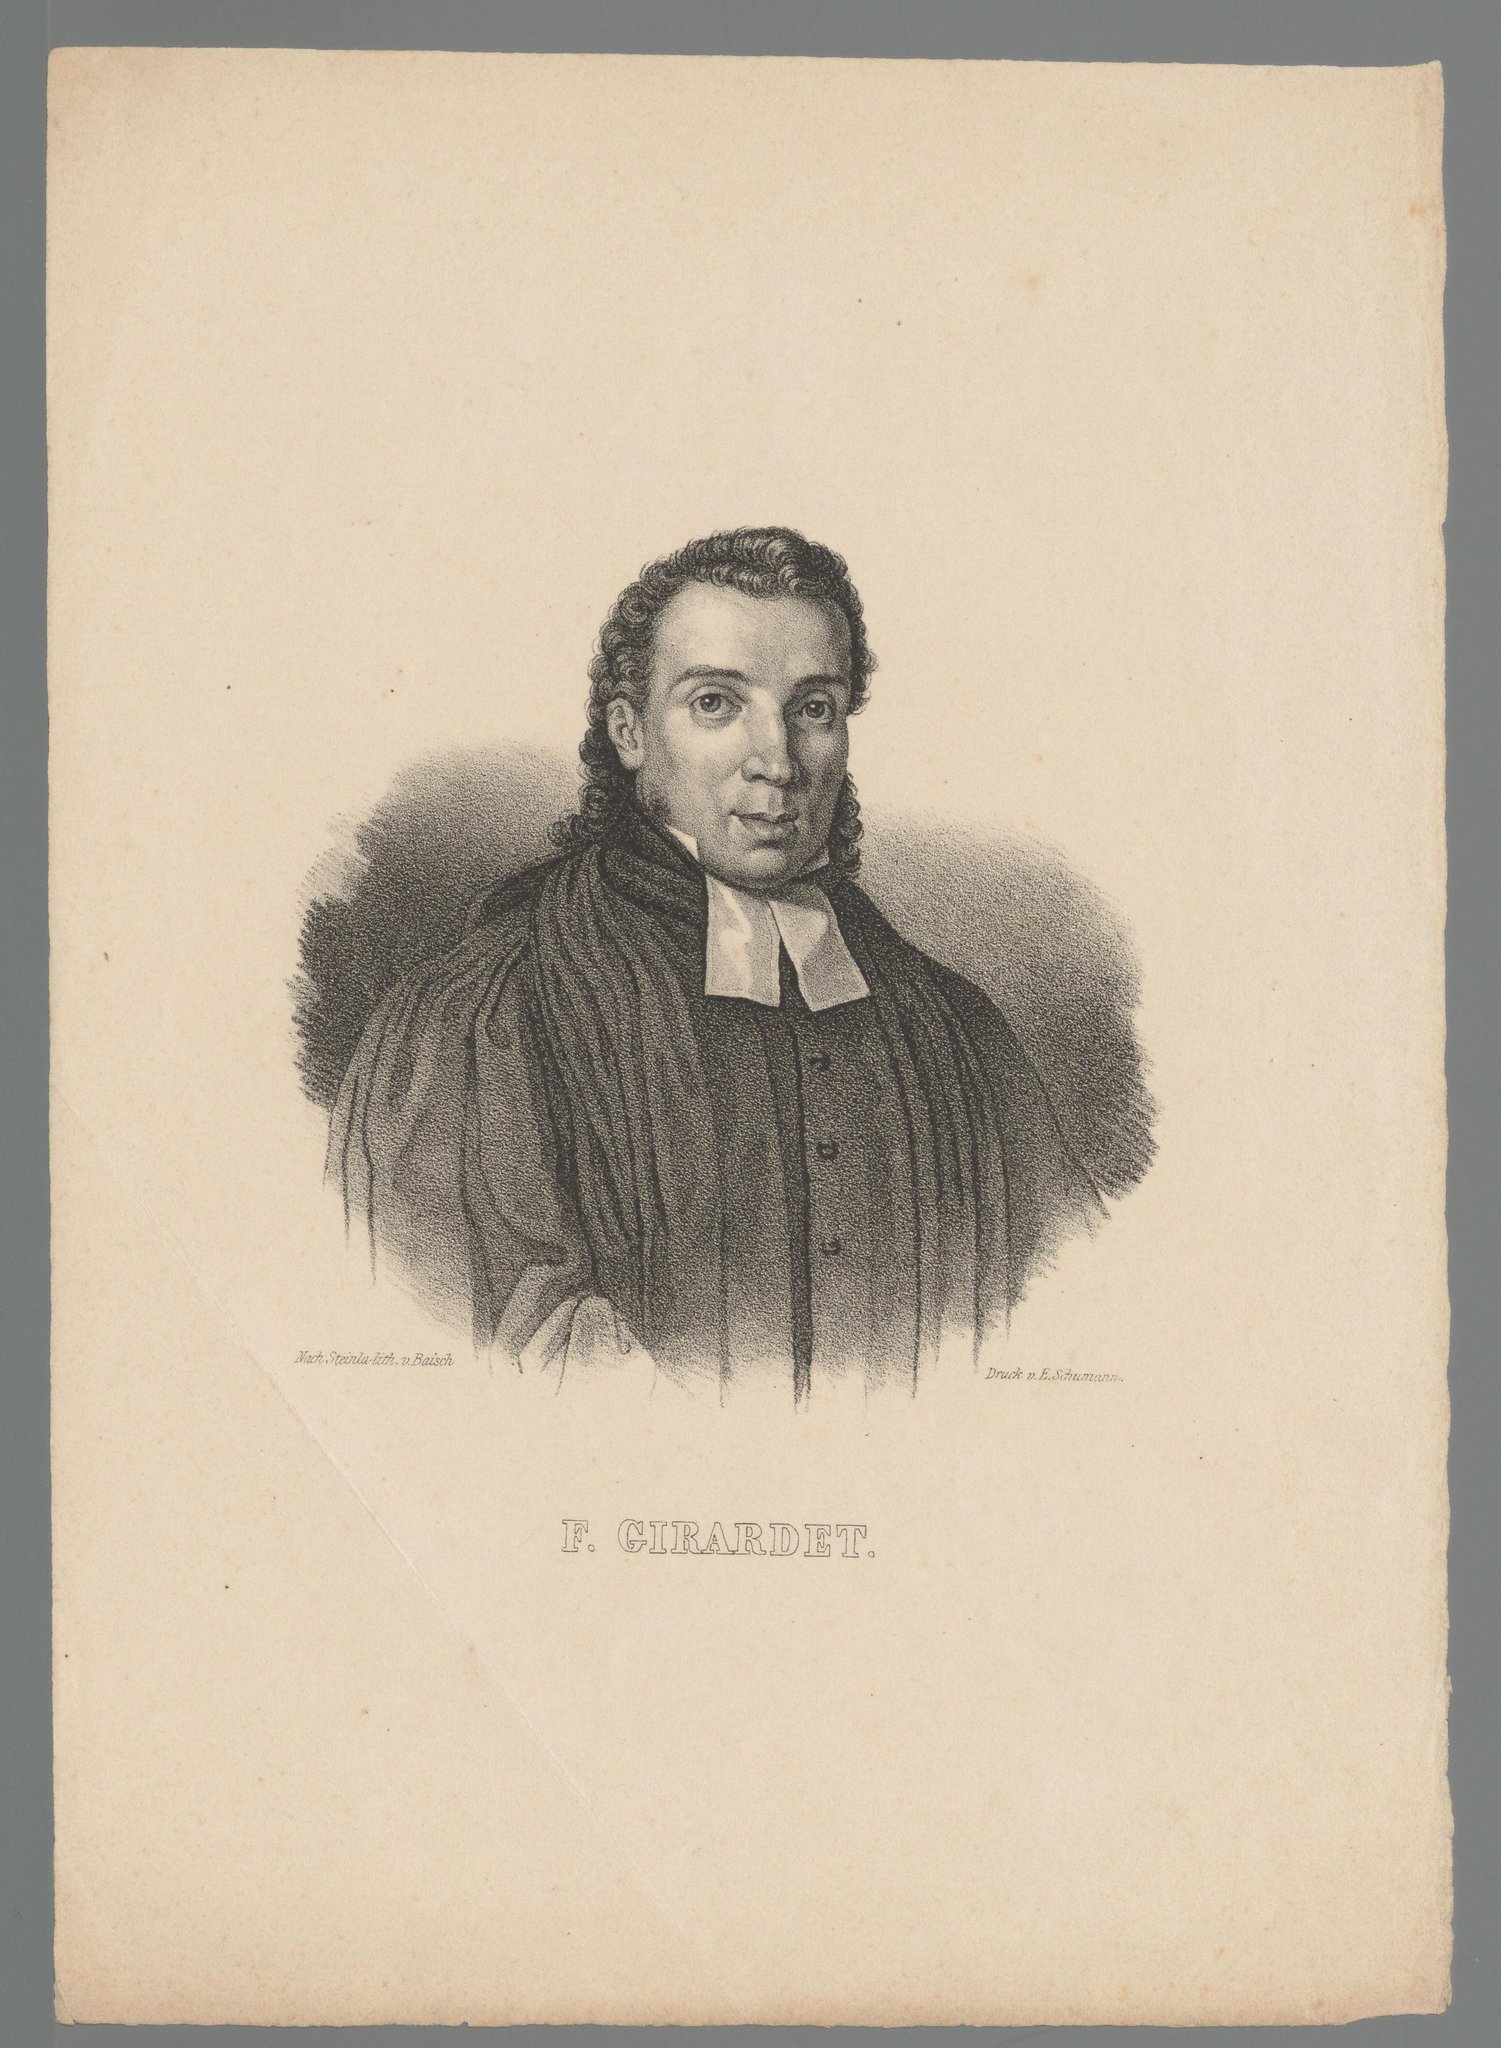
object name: print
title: Portret van Friedrich Christlieb Girardet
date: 1815-1864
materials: paper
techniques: lithograph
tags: theologian, historical persons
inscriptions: collector's mark: Lugt 2228